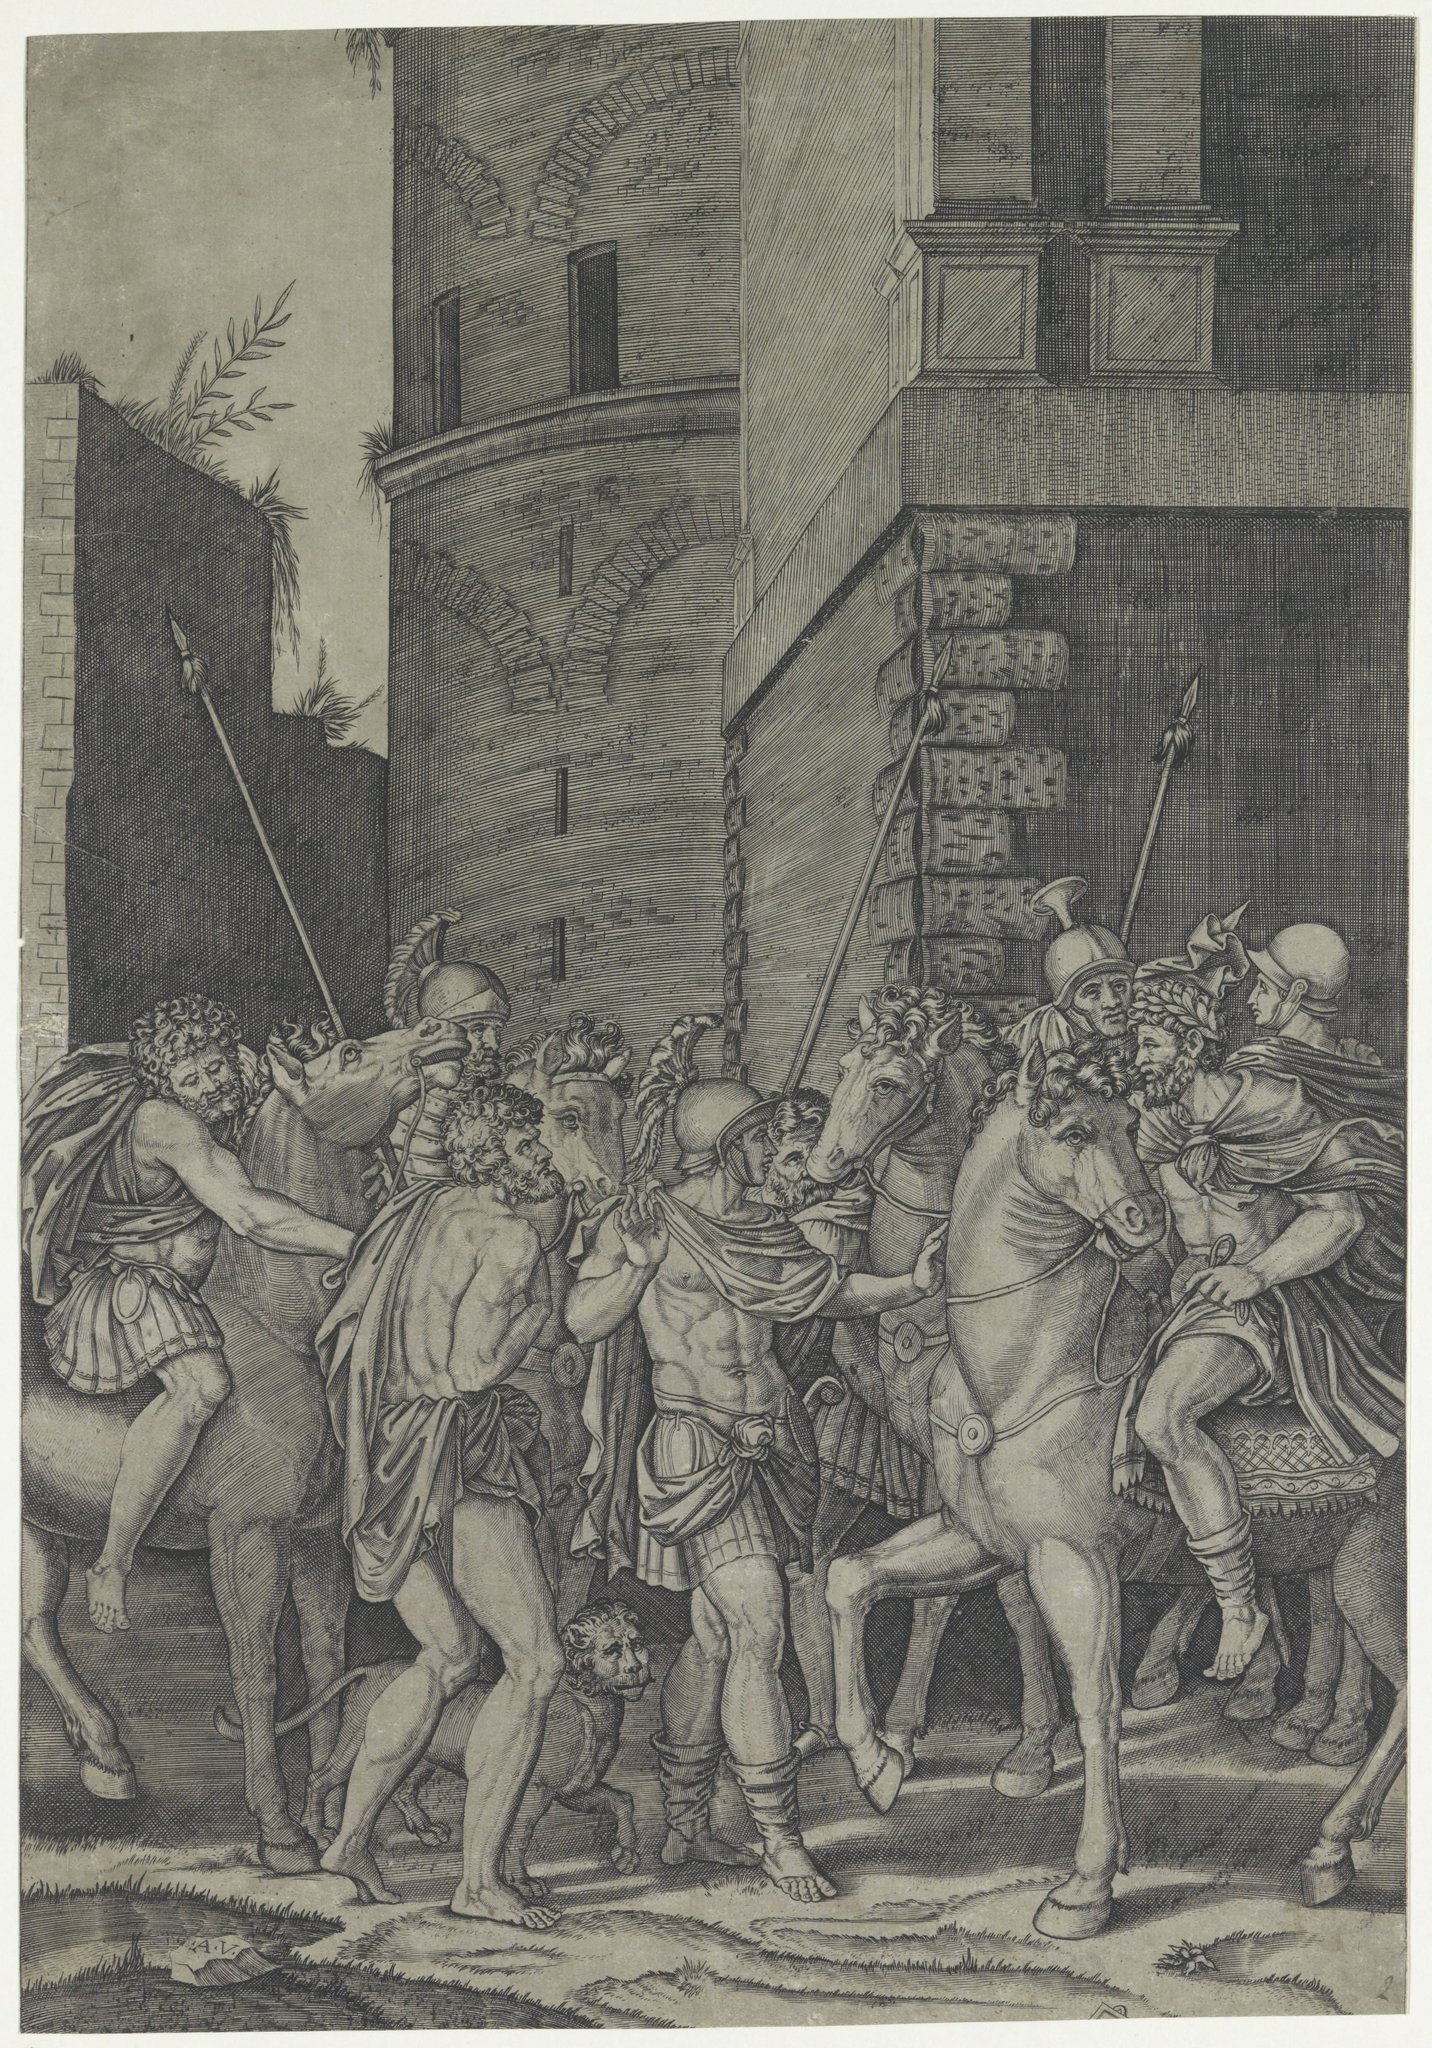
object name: print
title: Hadrianus ontmoet Androclus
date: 1500-1536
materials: paper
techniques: engraving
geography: italy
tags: androclus, when thrown to the lions in the arena, is not harmed, because he is recognized by the lion, whose paw he had cured (androclus is subsequently pardoned by the emperor hadrian)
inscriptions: number: ‘2’, collector's mark: ‘Hinloopen’, collector's mark: Lugt 10, collector's mark: Lugt 11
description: De Romeinse keizer Hadrianus, te paard, ontmoet Androclus die links staat te midden van Romeinse soldaten. Naast Androclus de leeuw uit wiens poot hij een doorn verwijderde.